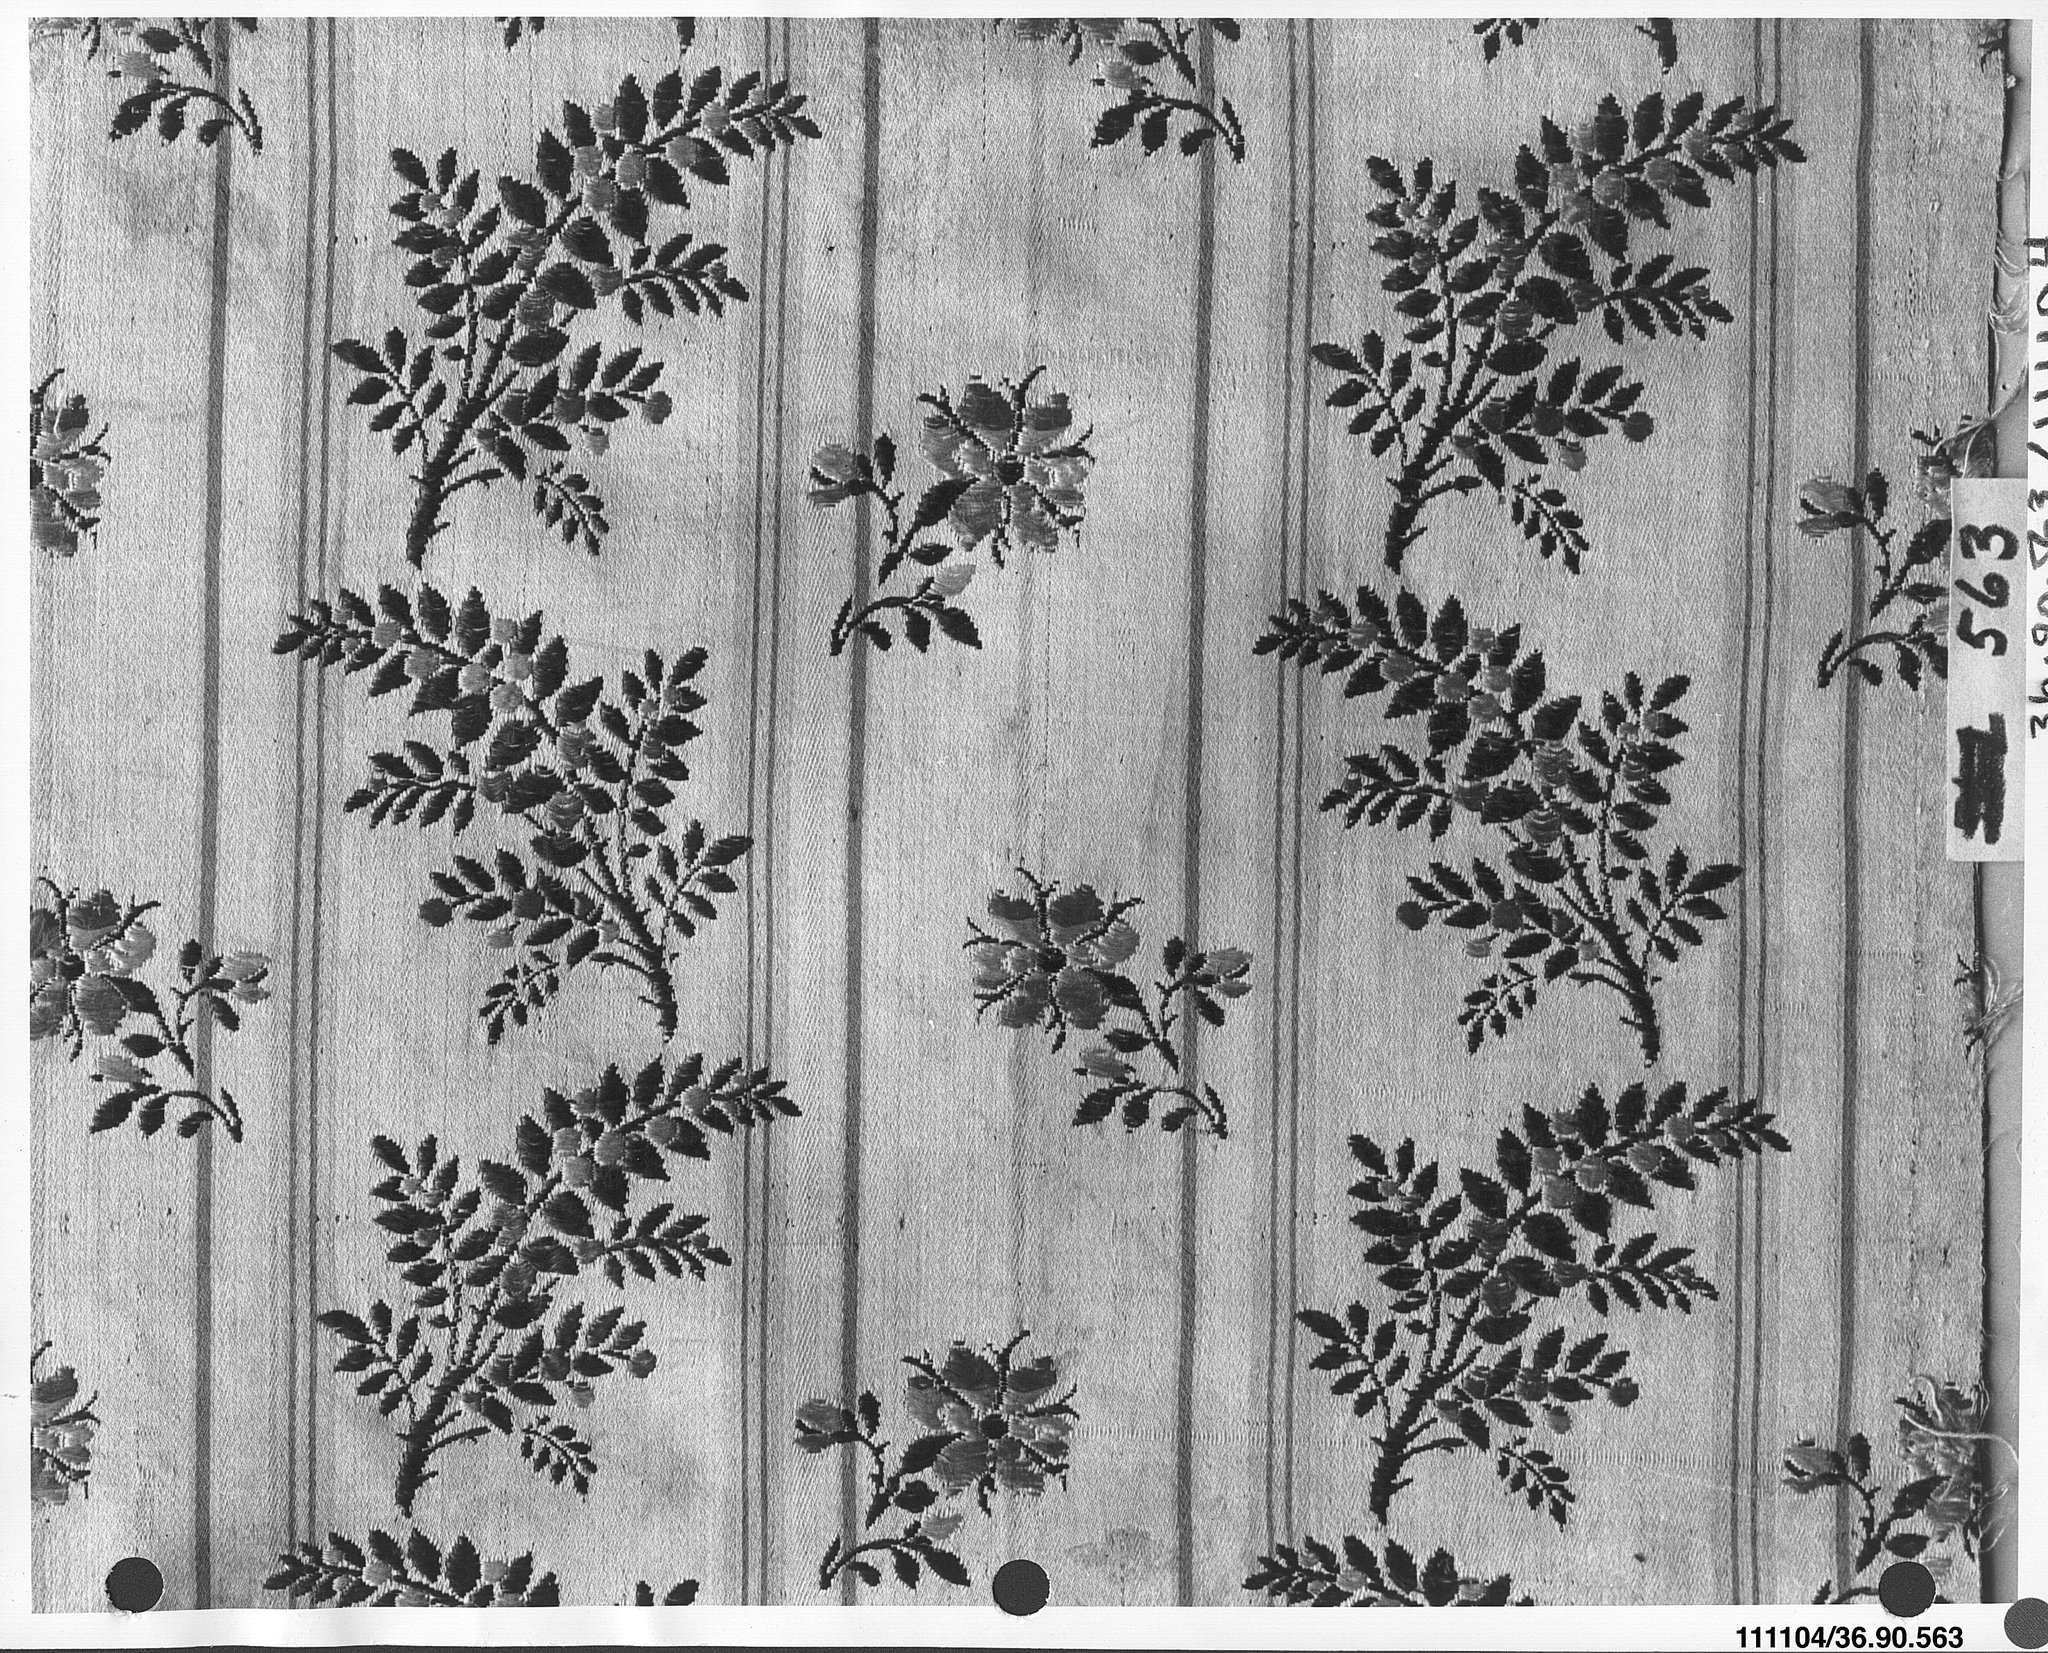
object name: piece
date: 1767-1800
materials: silk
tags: leaves